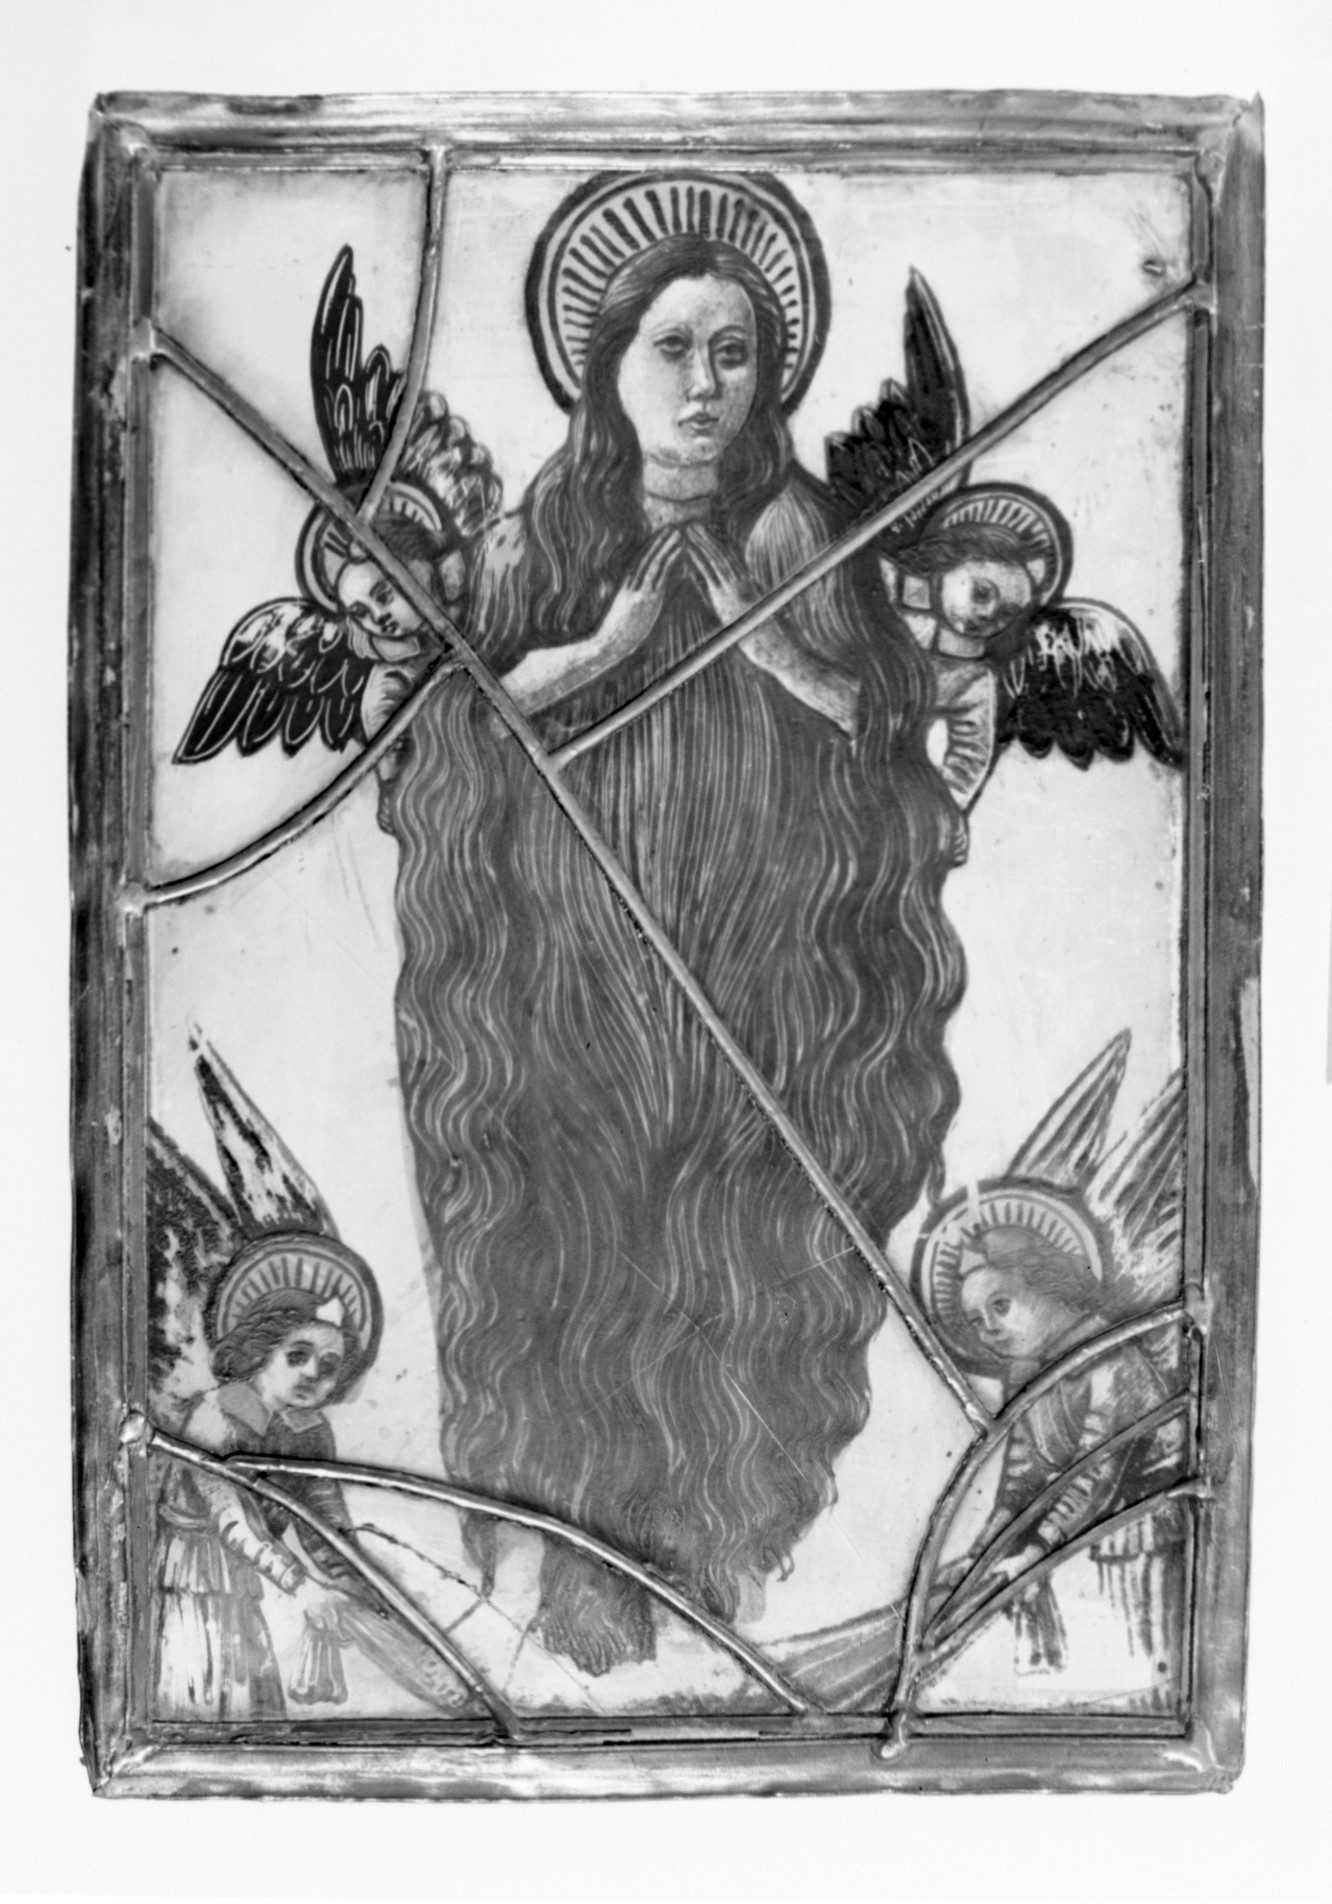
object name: panel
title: The Assumption of Mary Magdalene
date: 1501-1600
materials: glass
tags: angels,mary magdalene